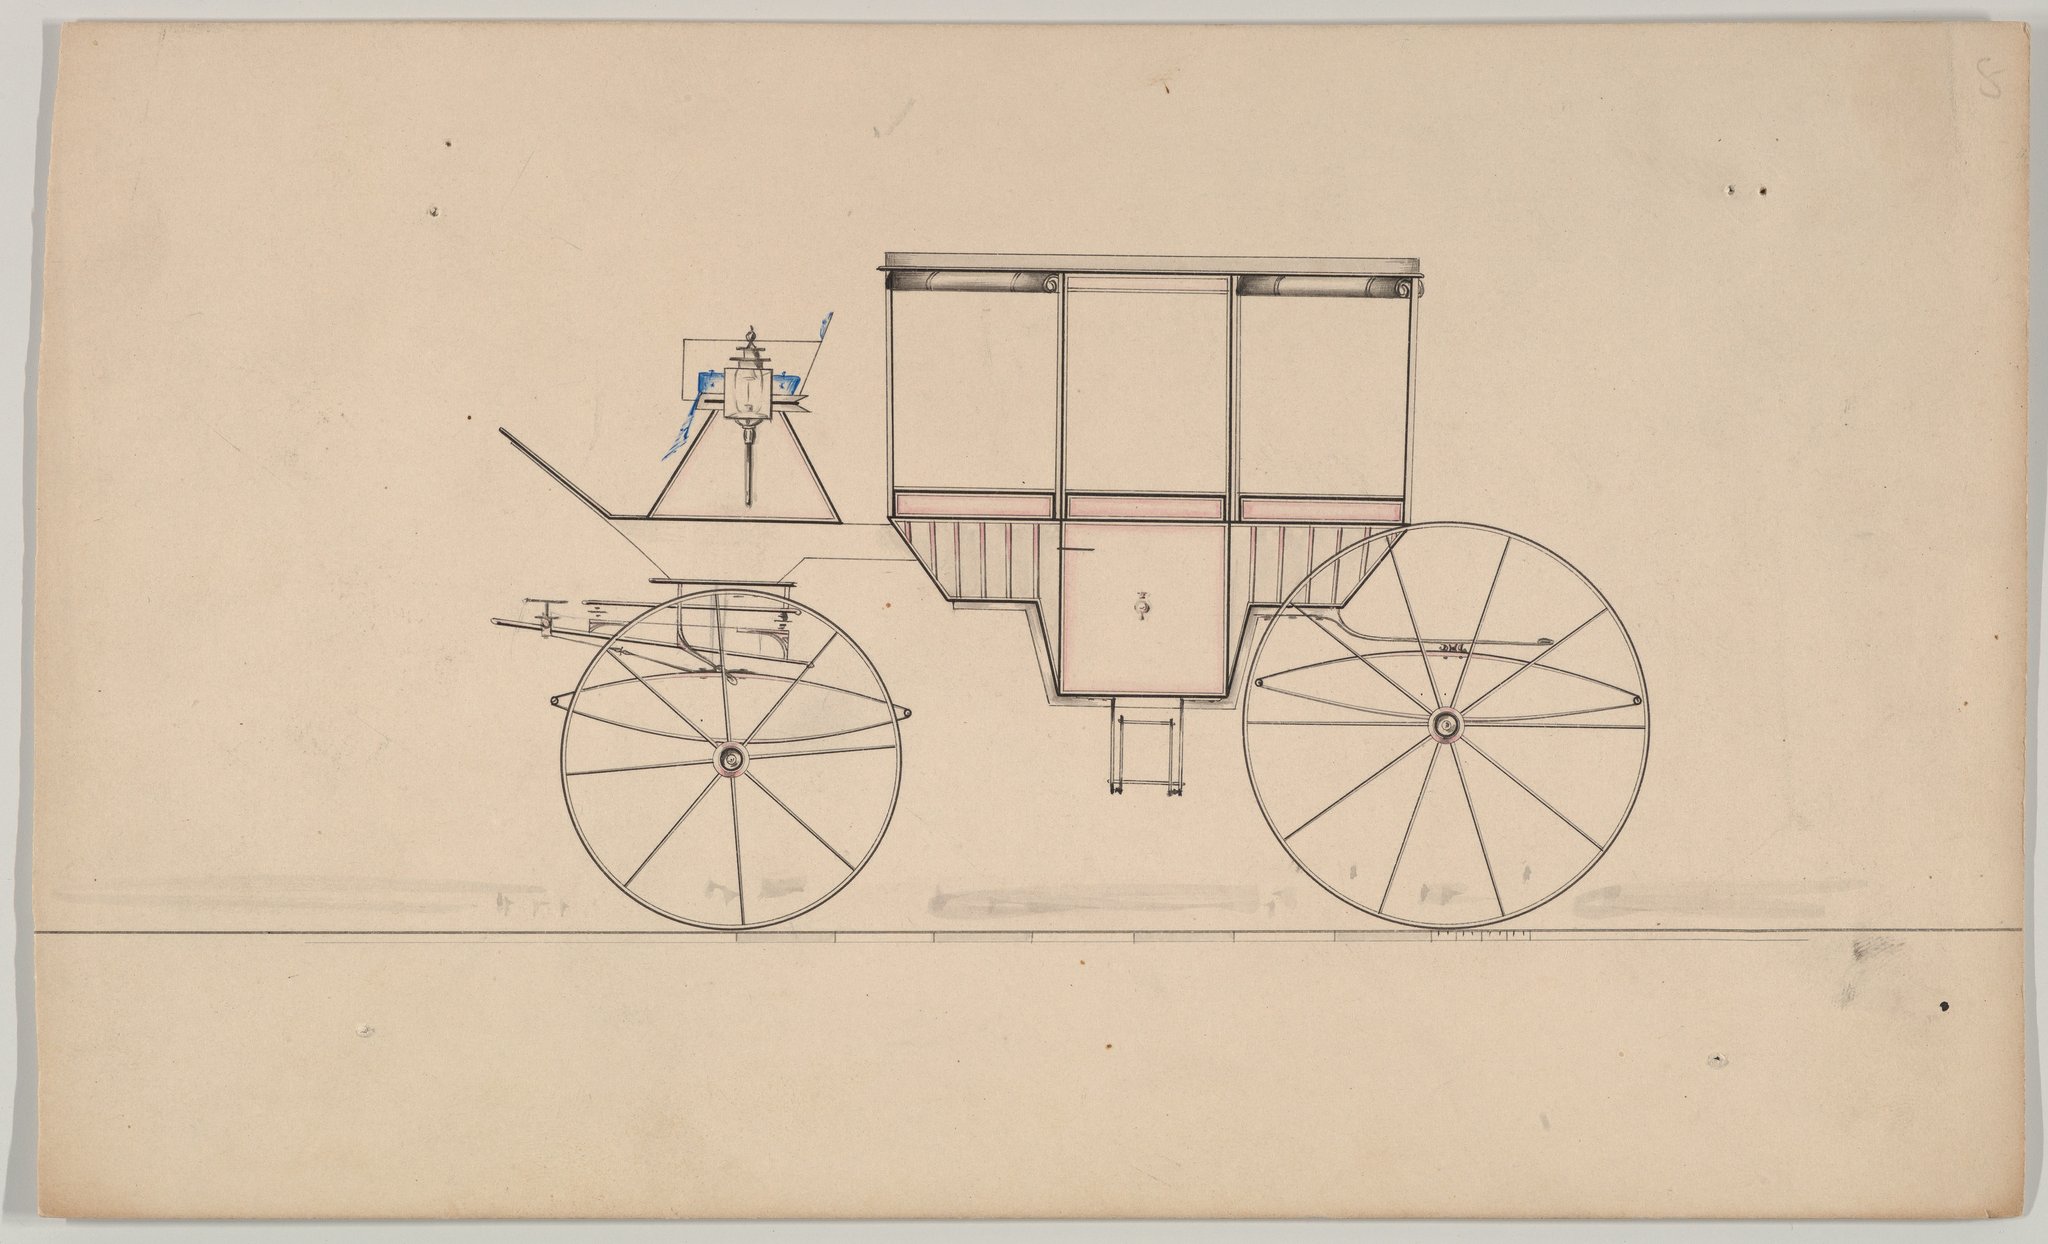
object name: drawing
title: Design for Vis-A-Vis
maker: brewster & co.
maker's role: manufacturer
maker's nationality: american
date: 1850-1870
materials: gouache, gum arabic, ink, watercolor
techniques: pen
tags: carriages